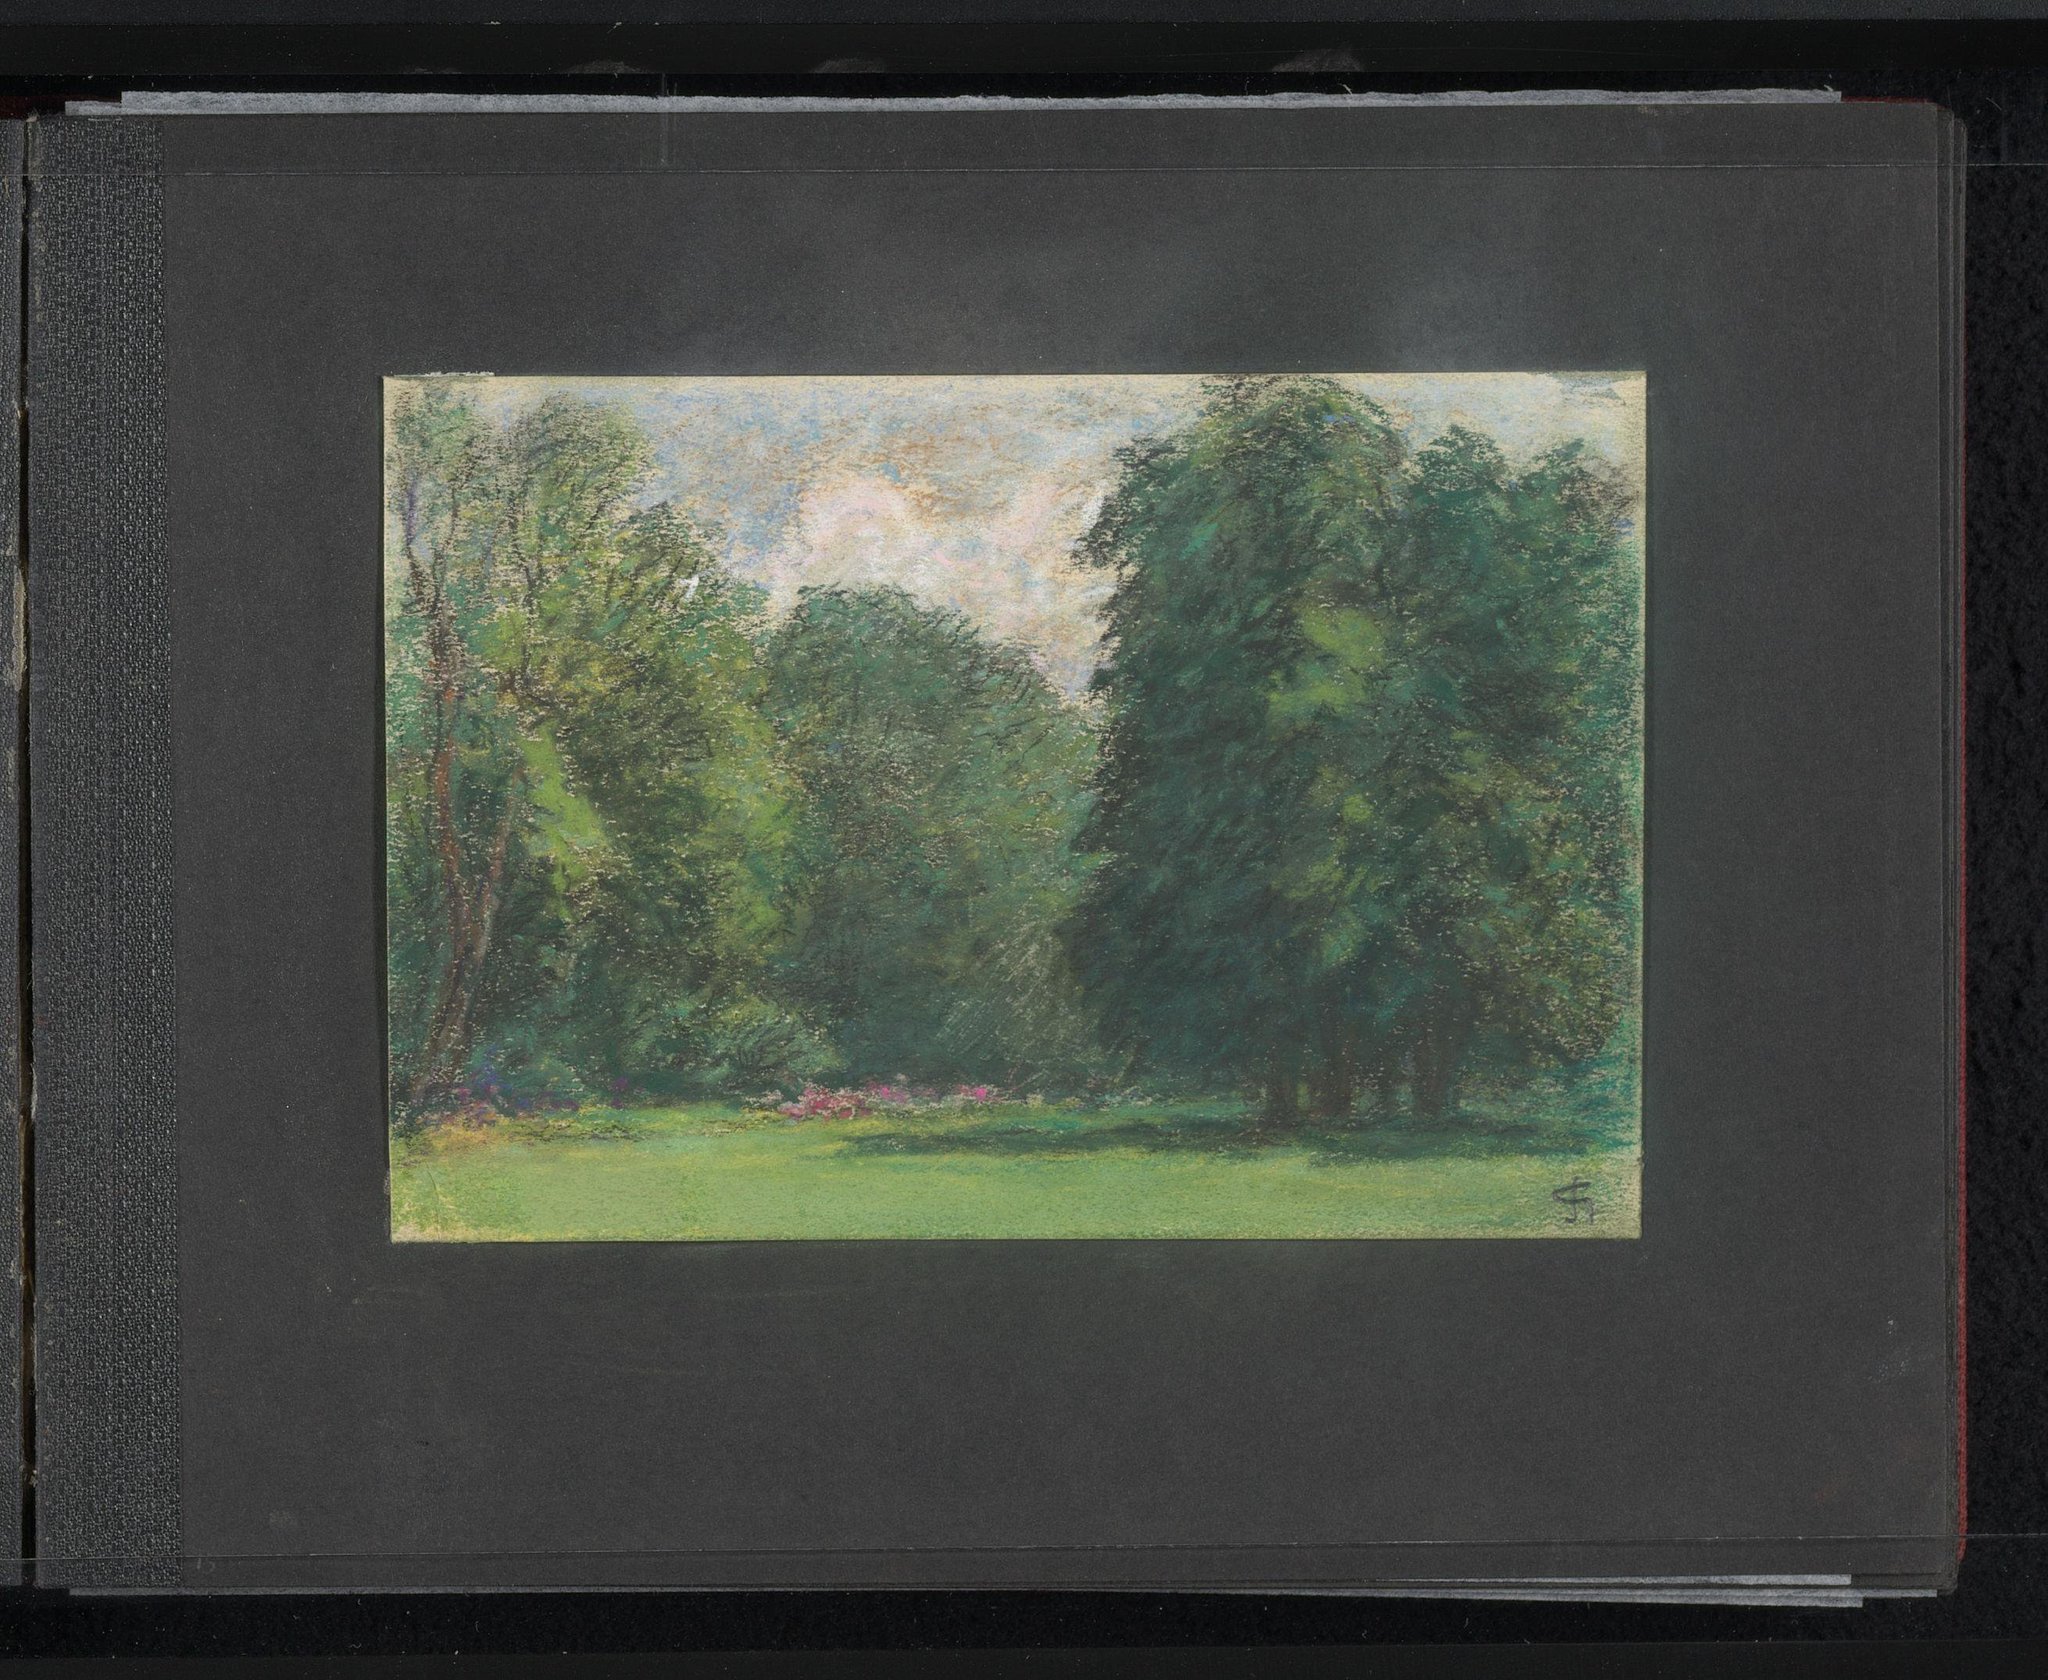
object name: drawing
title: Park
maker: carel nicolaas storm van s-gravesande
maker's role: draughtsman, print maker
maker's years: 1841-1924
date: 1915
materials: chalk, paper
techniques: pasting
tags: public gardens, park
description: Mogelijk te Wiesbaden. Tekening maakt deel uit van een album.